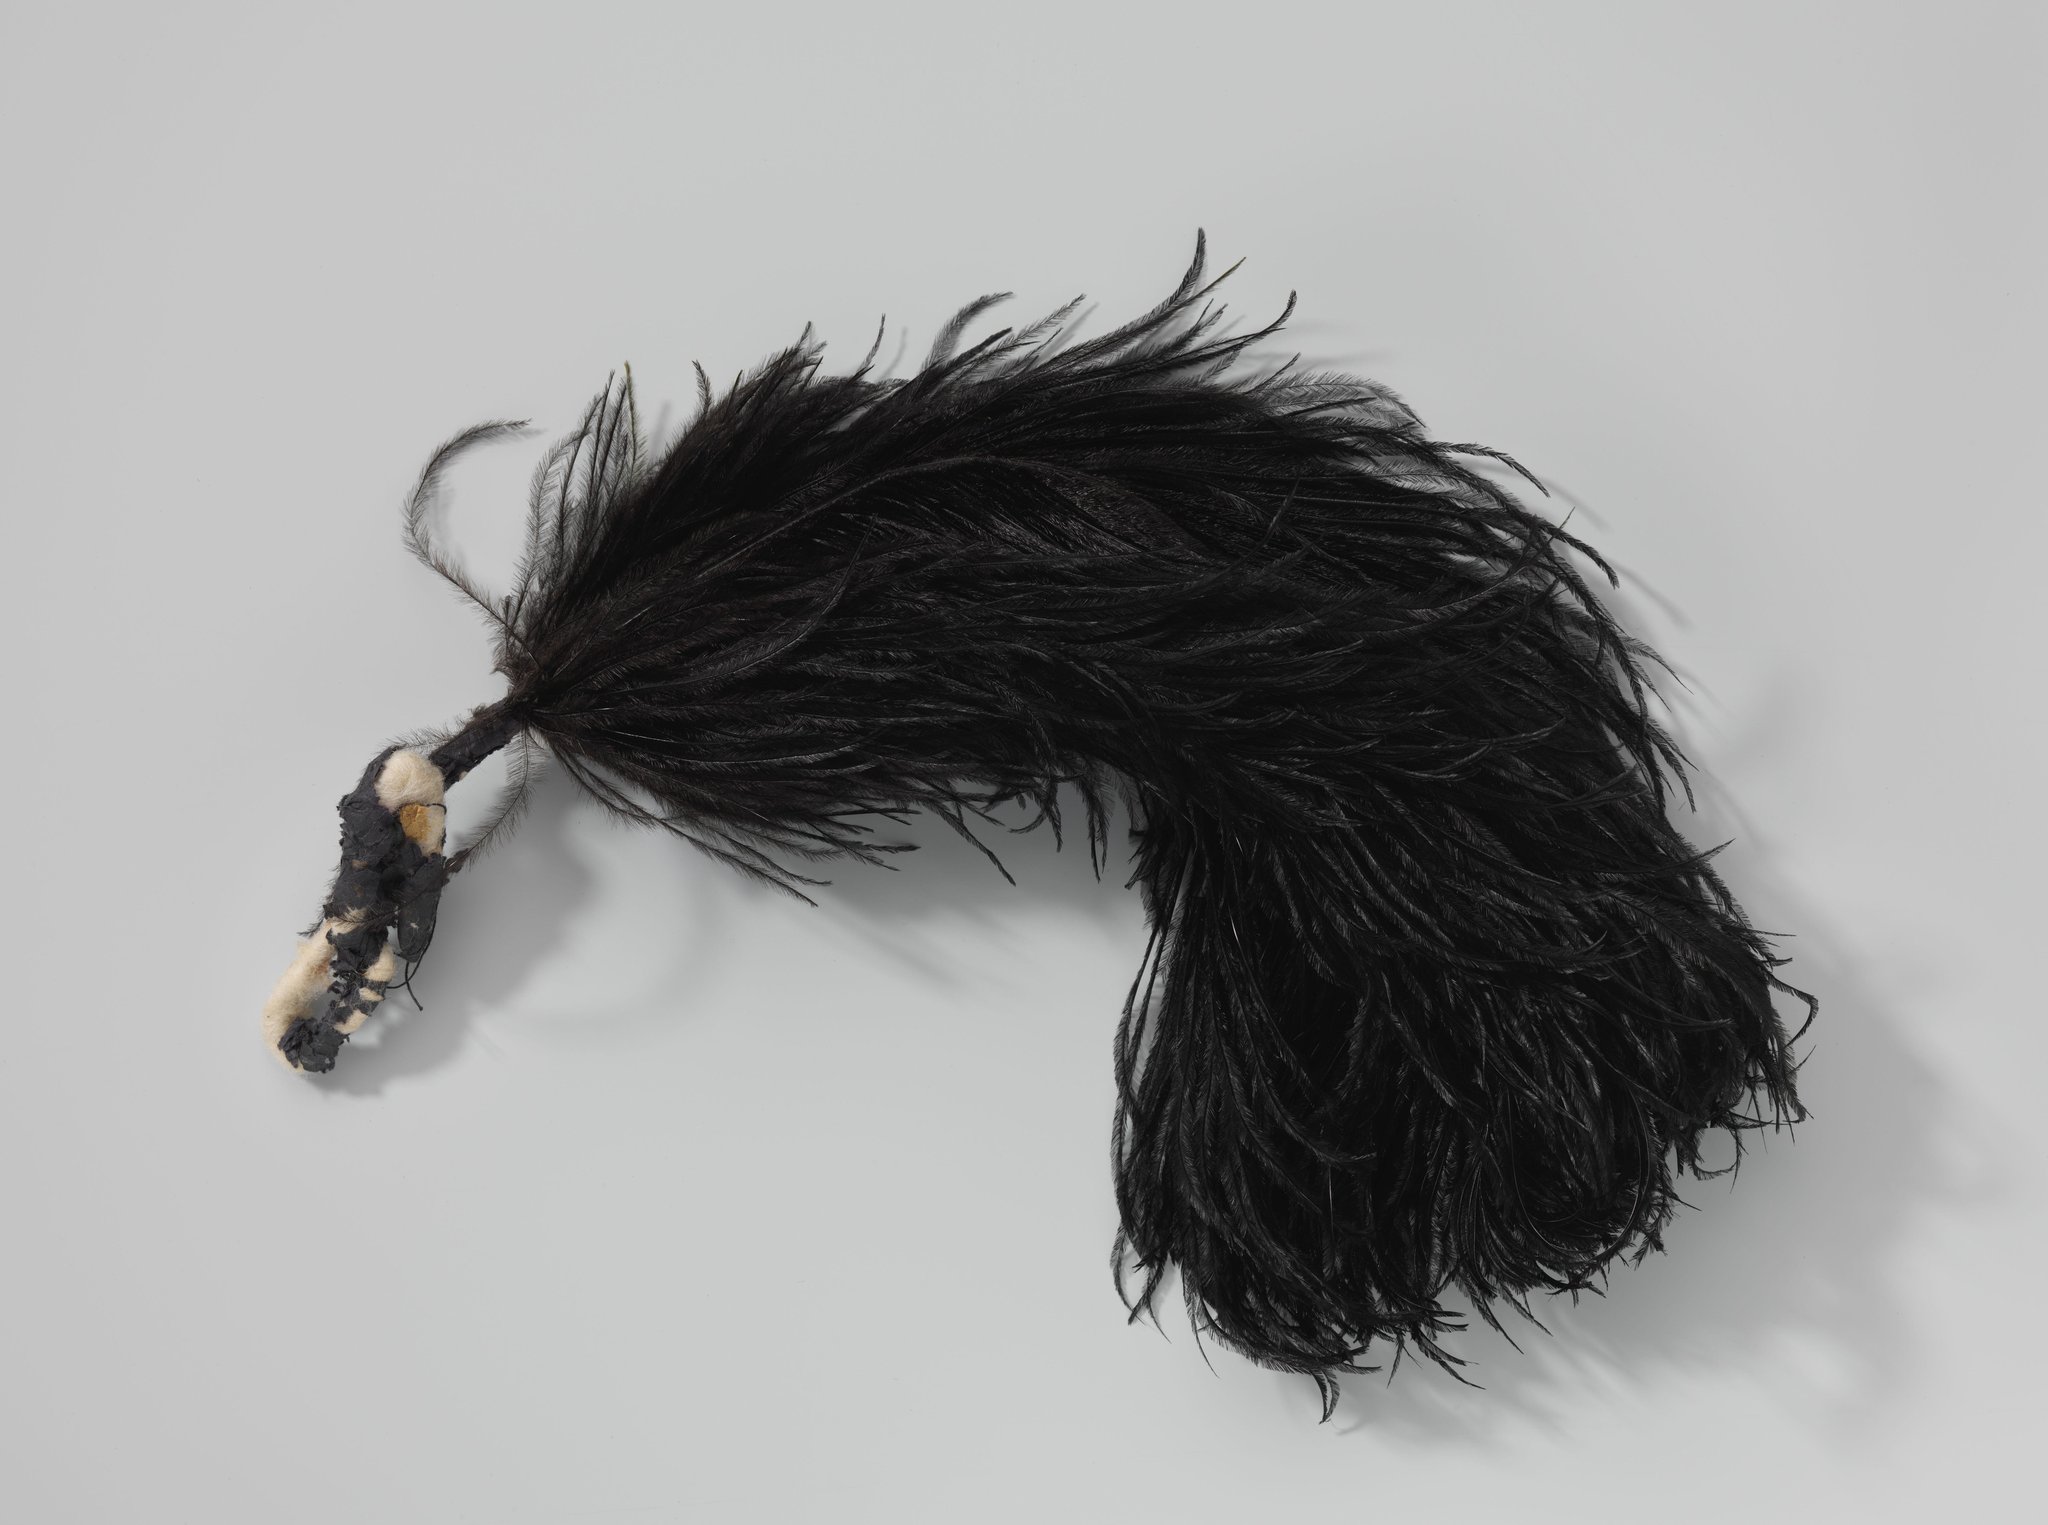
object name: hoedengarneersel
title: Toef struisveren, zwart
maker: Anonymous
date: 1880-1925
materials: metal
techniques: painting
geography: western europe